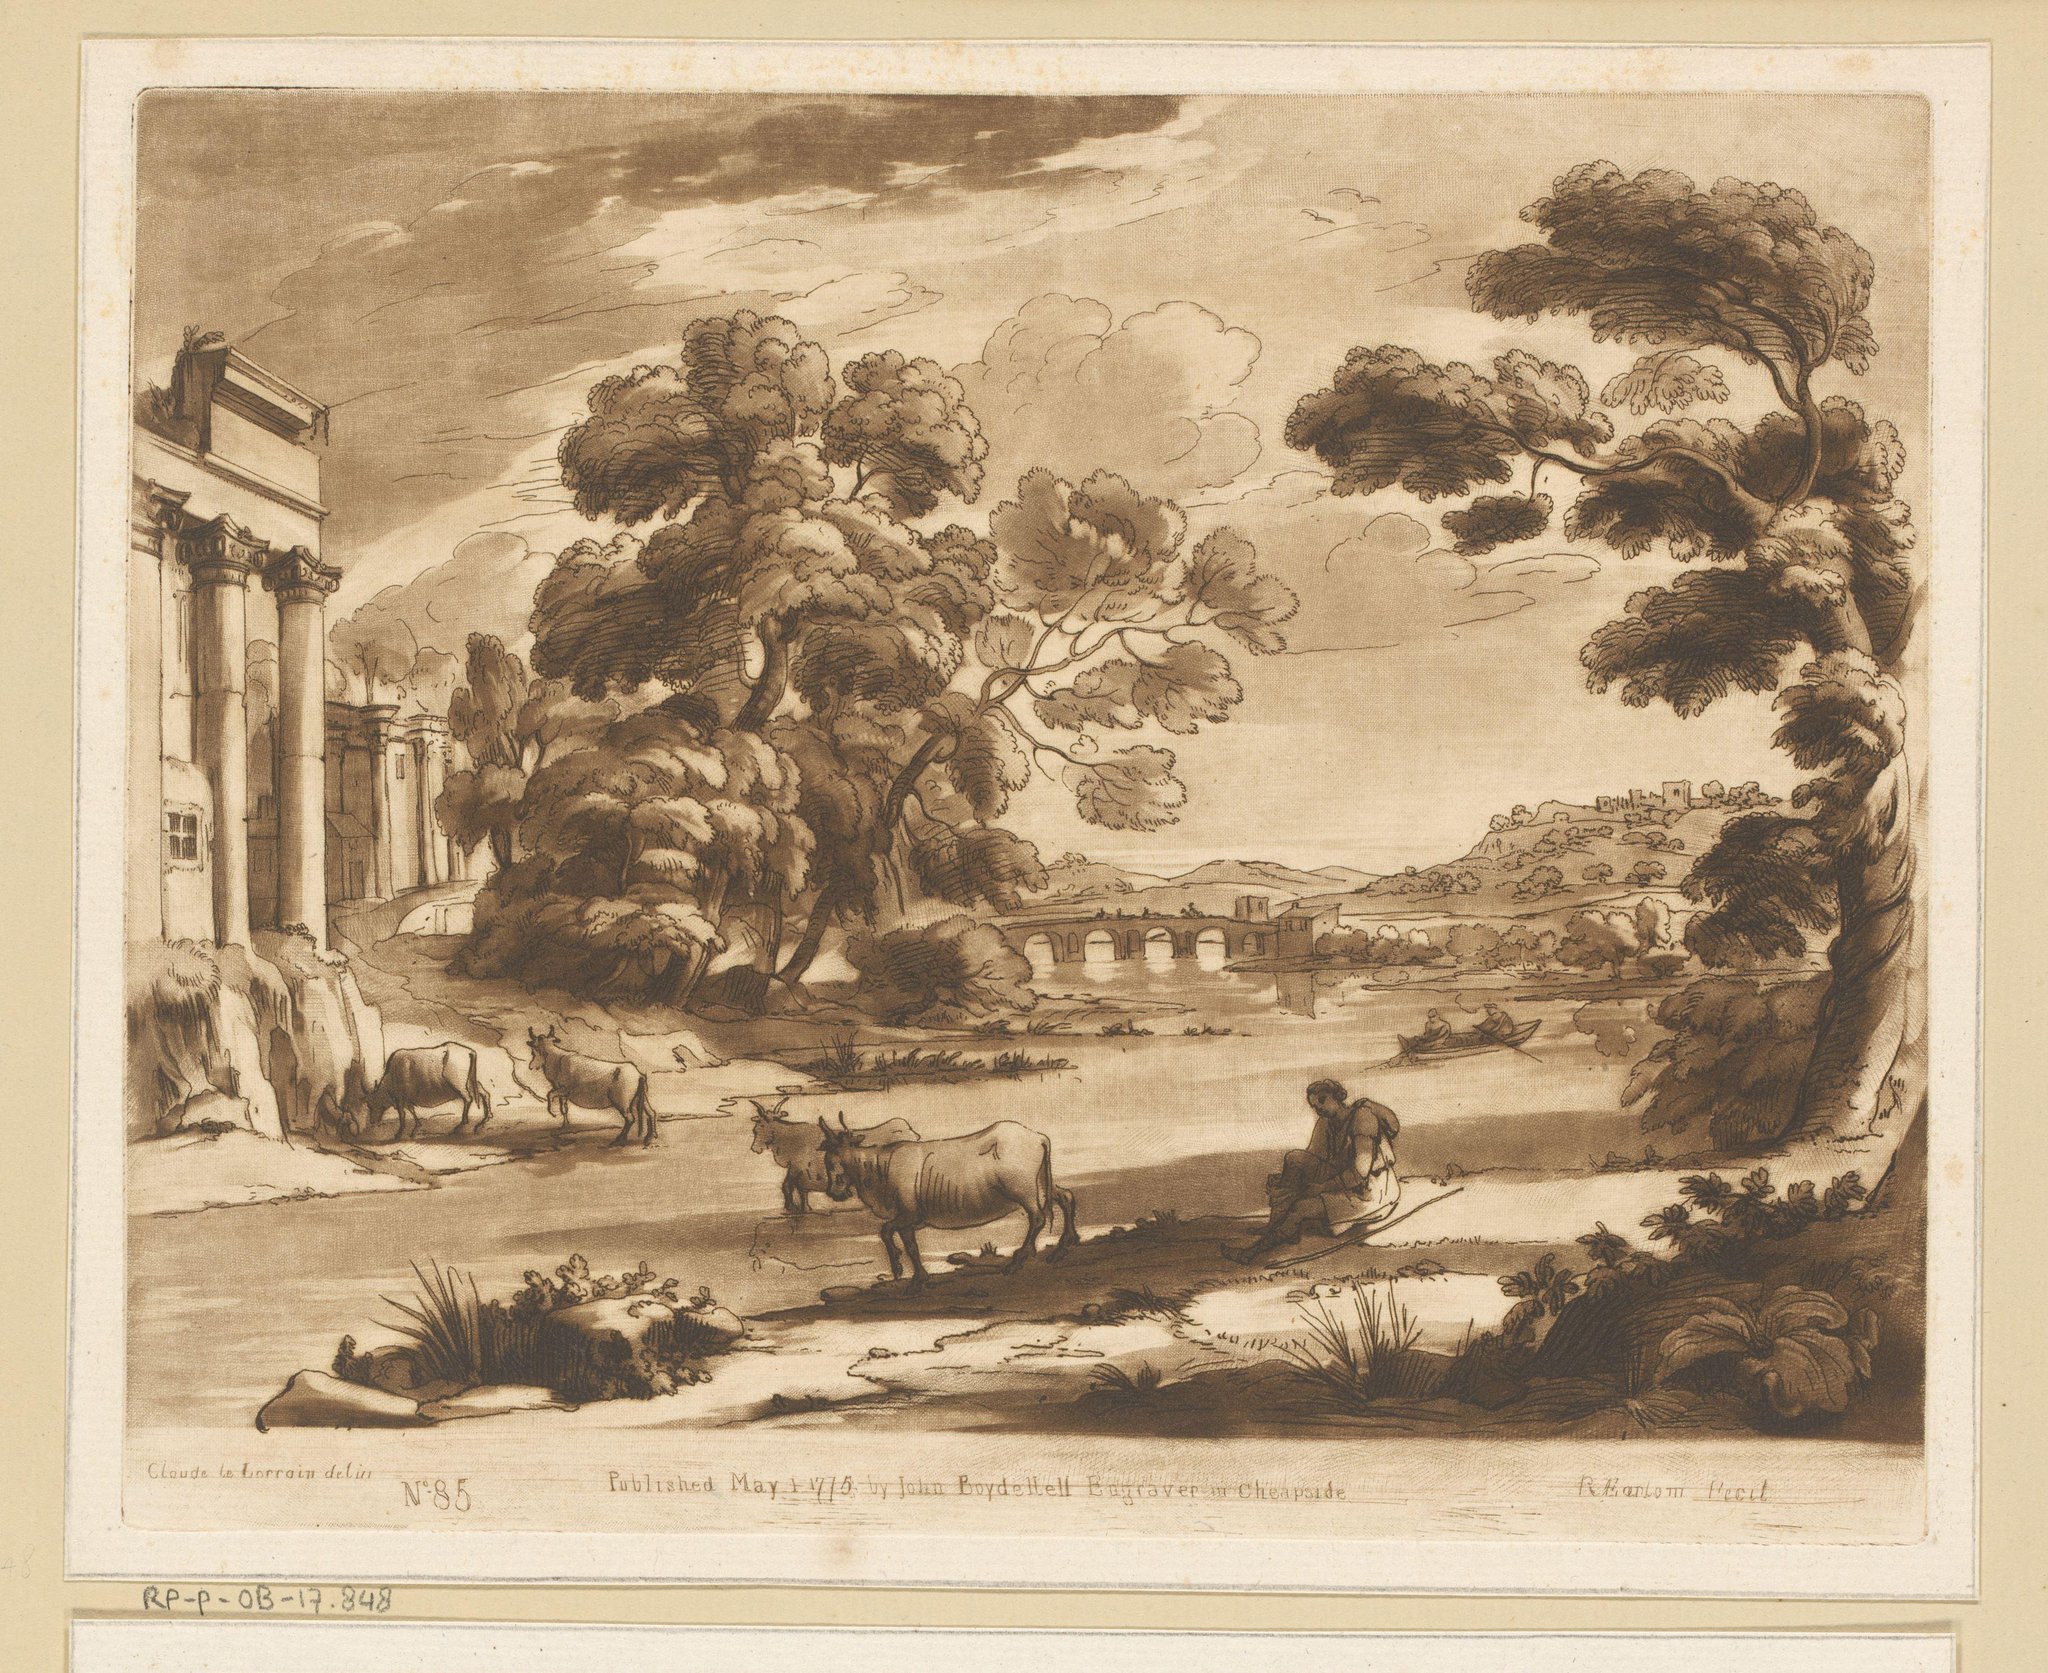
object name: print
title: Prenten naar tekeningen van Claude Lorrain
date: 1775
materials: paper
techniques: etching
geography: london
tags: river - hh - ideal landscapes, crossing a river, cattle driving, cattle driver, landscape with ruins - ii - ideal landscapes, pastorals, arcadian scenes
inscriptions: date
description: Vanaf 1774 publiceerde John Boydell tweehonderd prenten naar het tekeningenboek Liber Veritatis van Claude Lorrain, in het bezit van de hertogen van Cavendish. Deze prenten werden vanaf 1777 in twee volumes gebundeld uitgegeven.